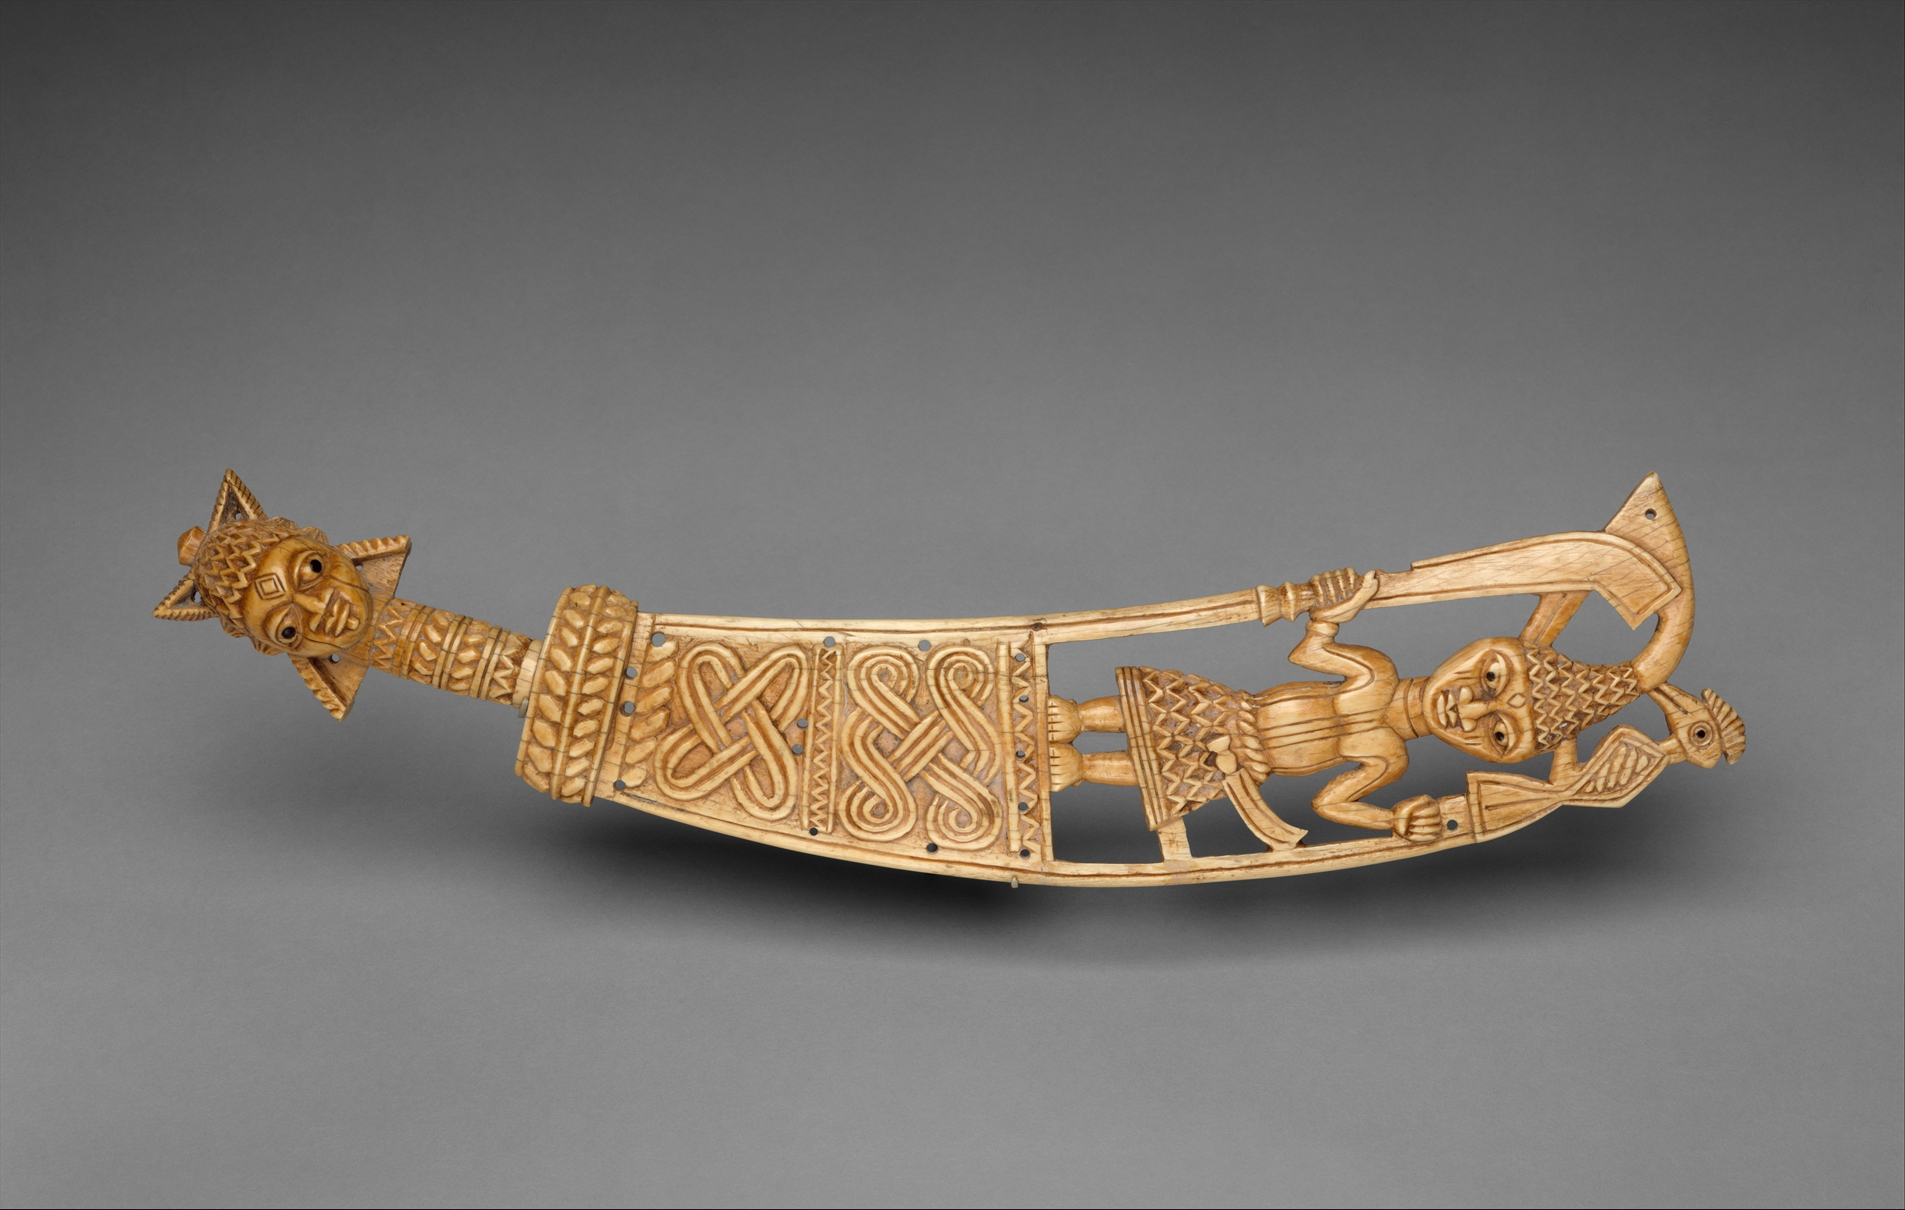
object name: sword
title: Udàmalóre (ceremonial sword)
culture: yoruba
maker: ijebu-yoruba artist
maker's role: artist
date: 1601-1800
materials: plant material, ivory, wood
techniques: inlay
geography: nigeria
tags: human figures,birds